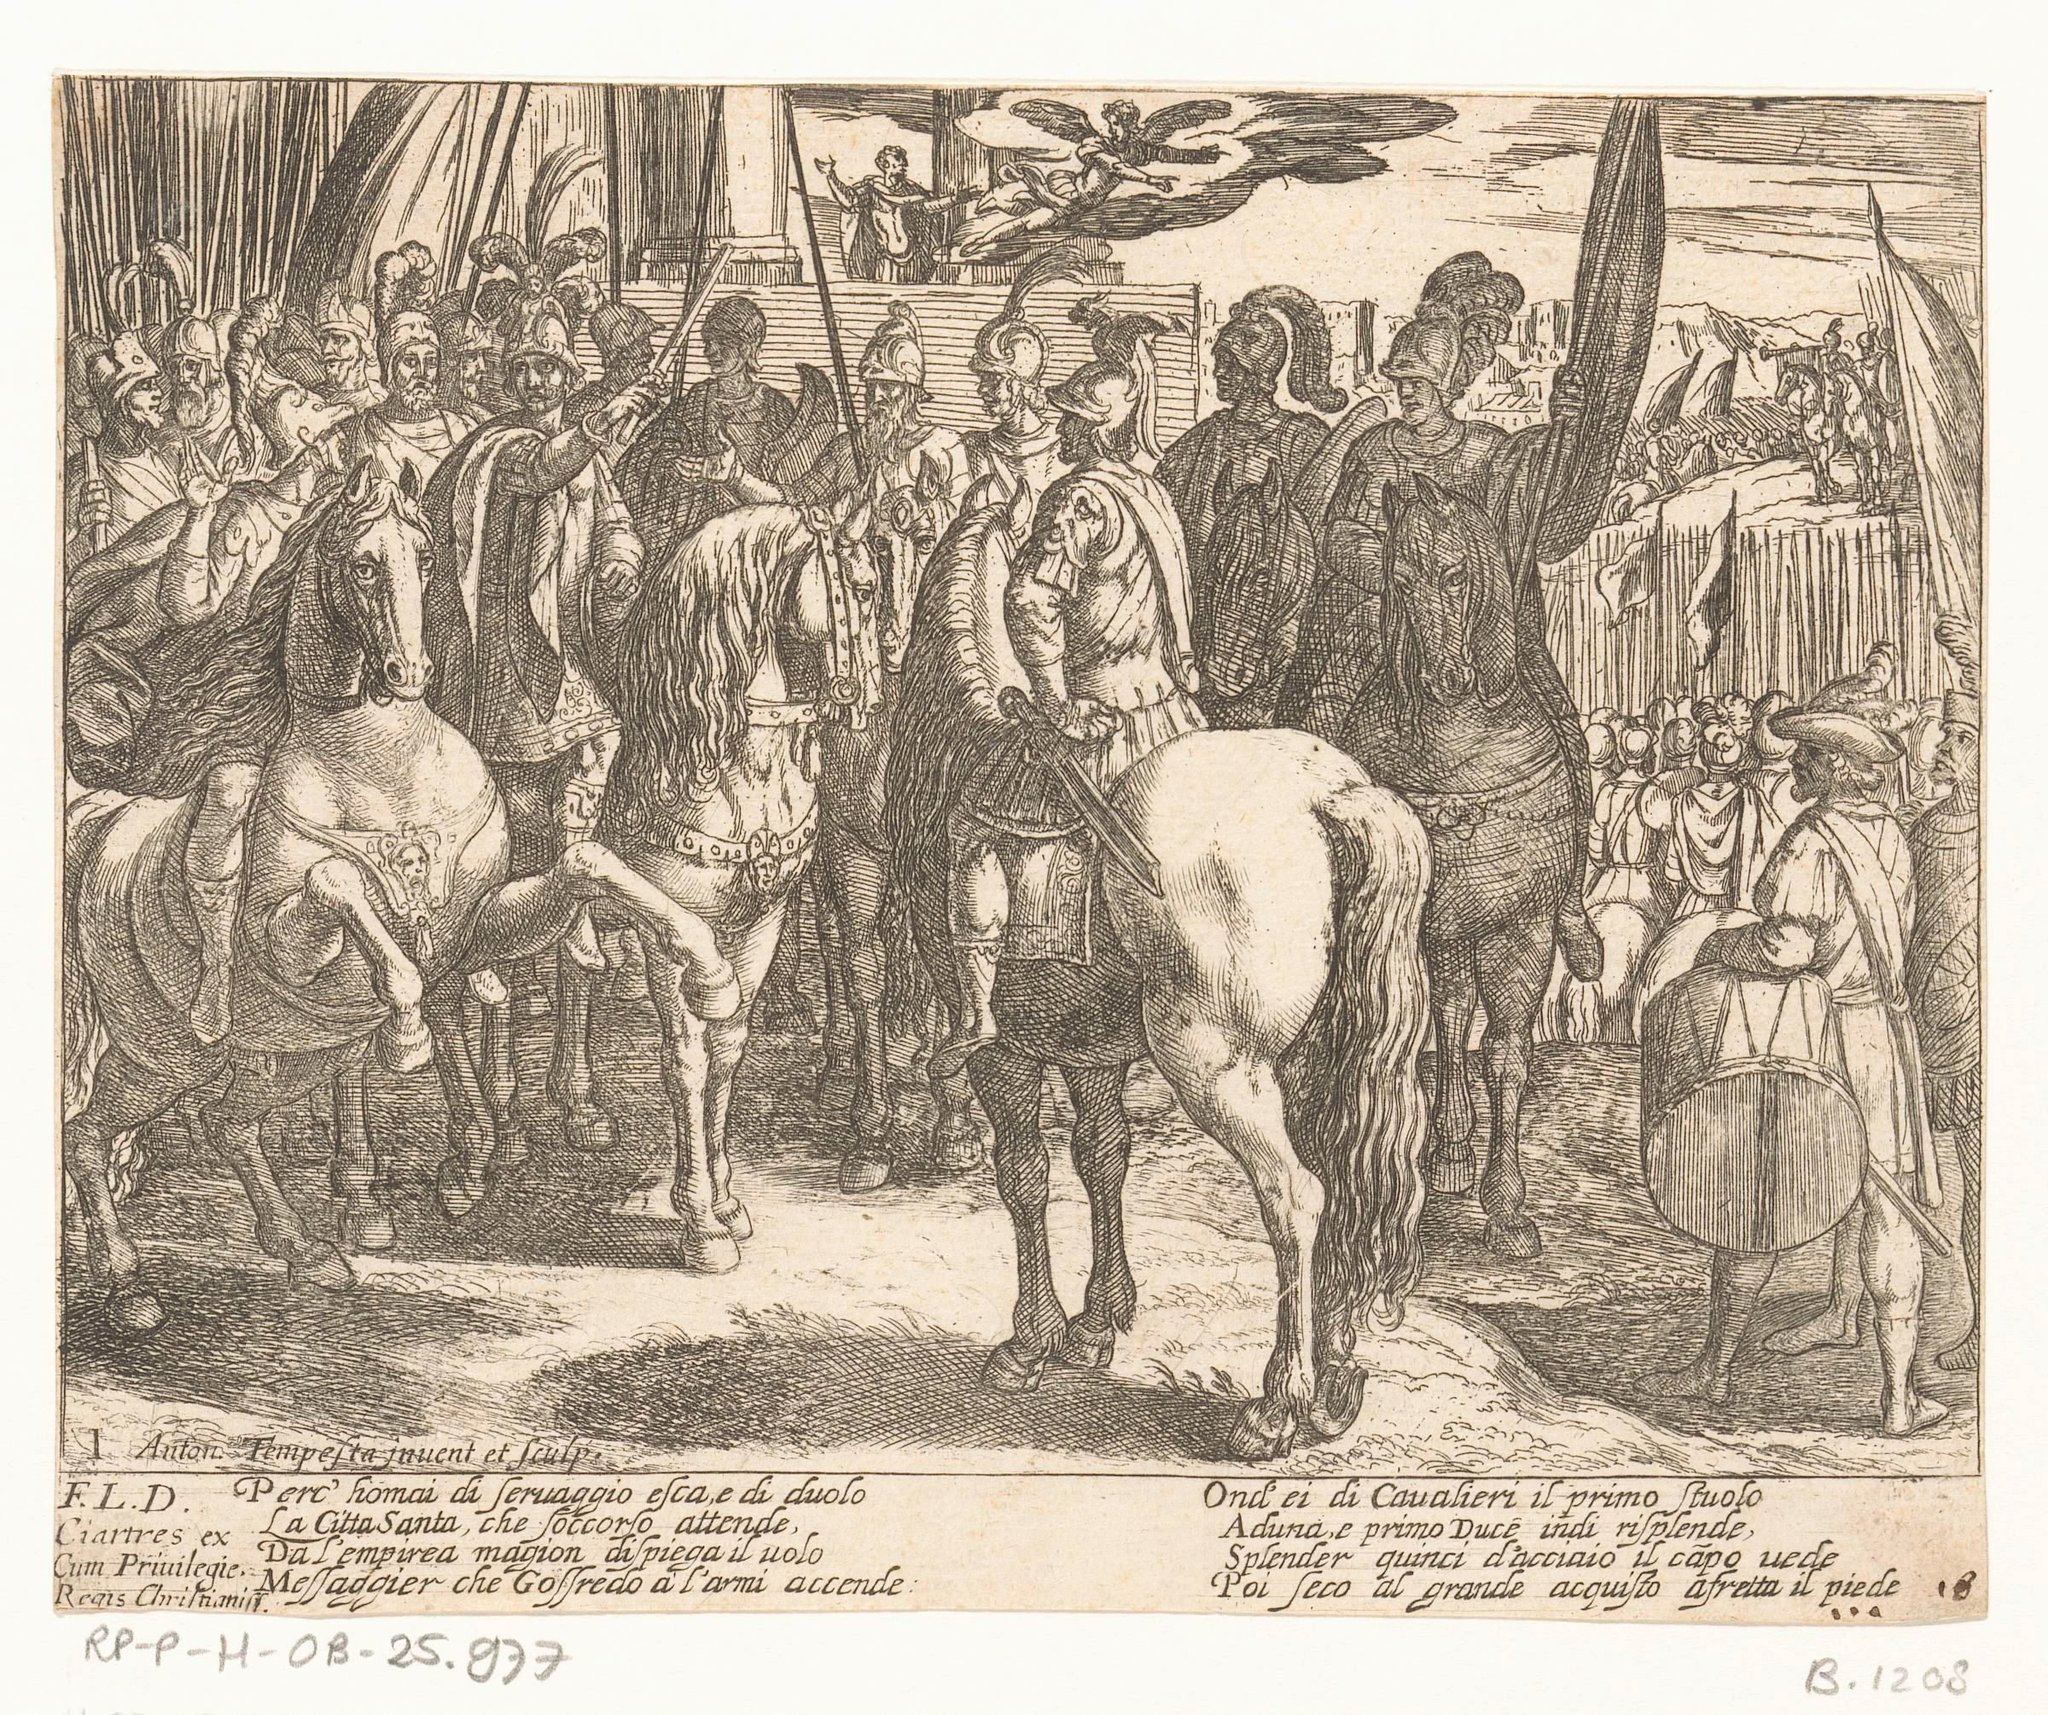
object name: print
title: Jeruzalem verlost (deel 2)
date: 1565-1630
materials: paper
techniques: etching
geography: italy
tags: militant proselytizing: religious war, crusade, etc., (scenes from) specific works of literature: tasso, gerusalemme liberata, knight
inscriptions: number: ‘18’, collector's mark: Lugt 11, collector's mark: ‘Hinloopen’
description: Deze prent maakt deel uit van een reeks van twintig prenten (+ opdracht) met voorstellingen van scènes uit Tasso's 'Jeruzalem verlost', een episch gedicht geschreven door de Italiaanse dichter Torquato Tasso en voor het eerst gepubliceerd in 1581. Het verhaal vertelt grotendeels in fictie over de Eerste Kruistocht waarin de christenen, geleid door Godfried van Bouillon, de strijd aangaan met de moslims om het Beleg van Jeruzalem.